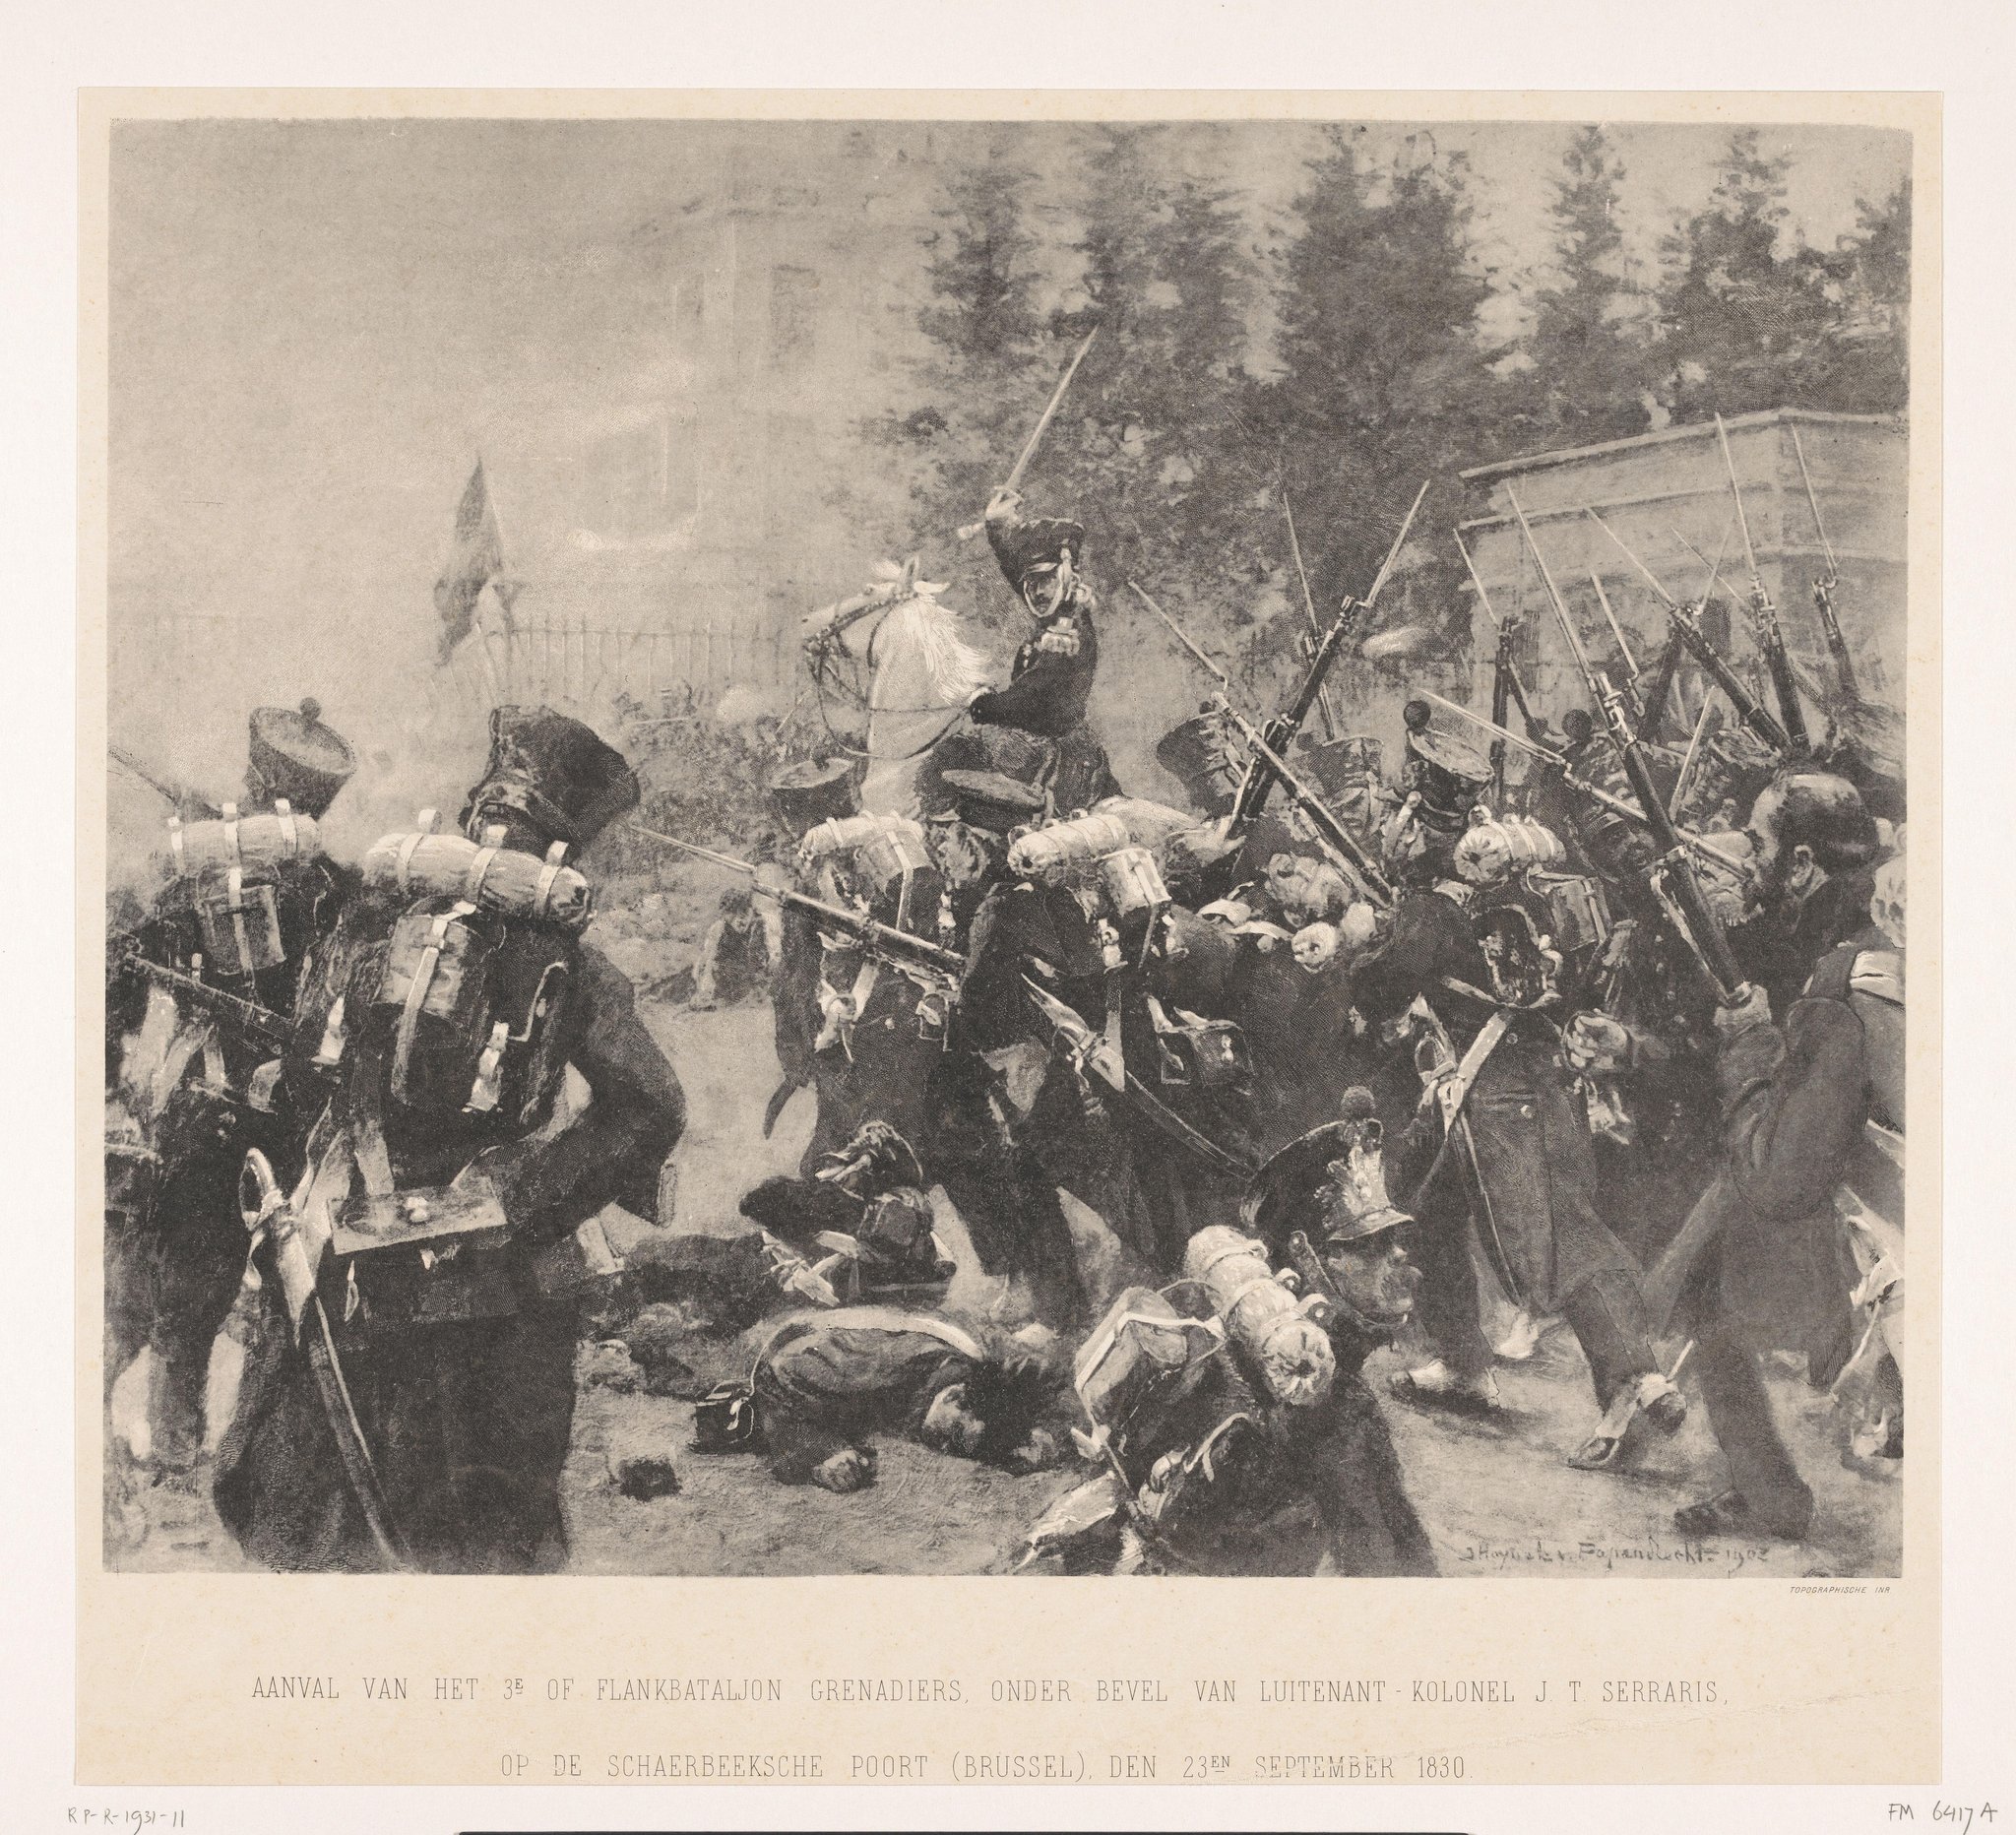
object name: reproduction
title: Schilderij van de aanval op de Schaerbeekse Poort te Brussel, 1830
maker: jan hoynck van papendrecht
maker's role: draughtsman, painter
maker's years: 1858-1933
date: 1902-1905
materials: paper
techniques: photograph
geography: netherlands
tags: charge ~ battle (+ infantry), brussels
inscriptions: collector's mark: Lugt 2228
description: Reproductie van het schilderij van Hoynck van Papendrecht voorstellende de aanval van het 3e bataljon grenadiers onder bevel van luitenant-kolonel Jan Theodoor Serraris op de Belgische opstandelingen bij de Schaarbeekse Poort te Brussel, 23 september 1830.